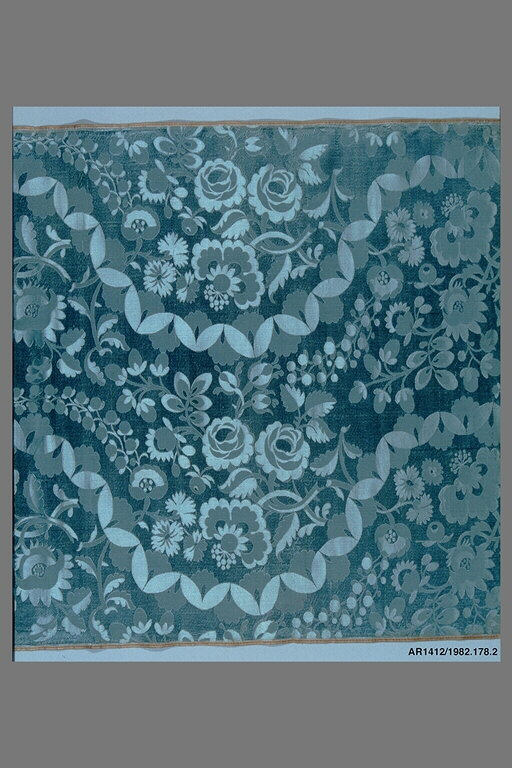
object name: length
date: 1750-1760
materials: silk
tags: flowers